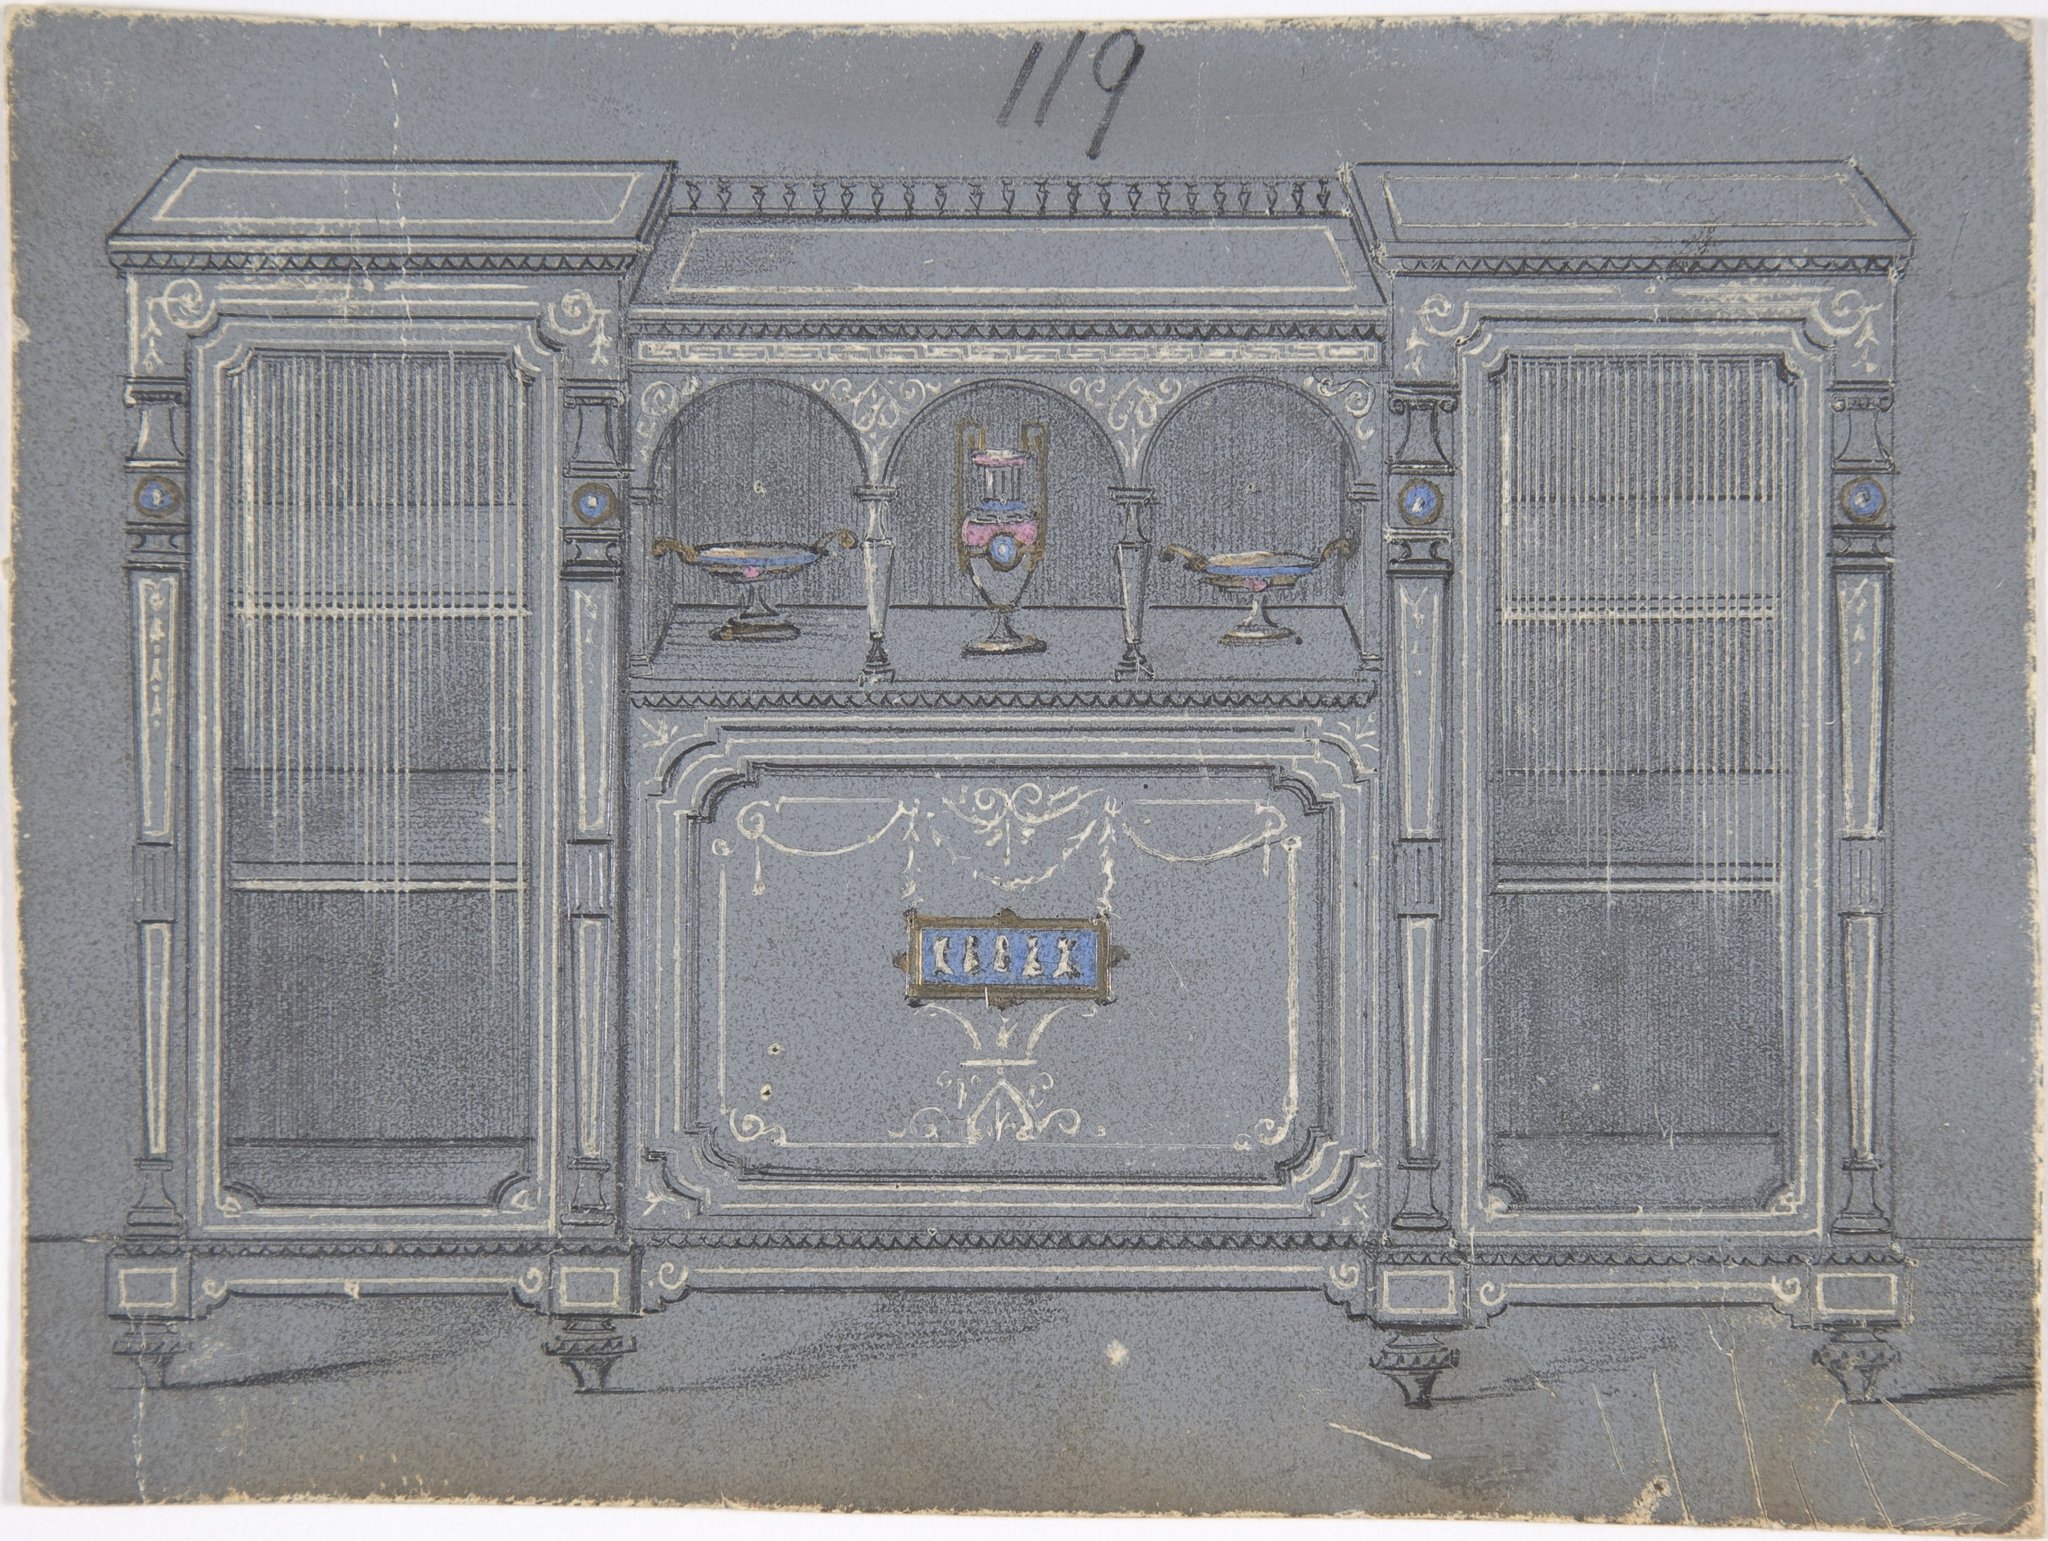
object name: drawing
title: Cabinet Design with a Porcelain Plaque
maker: anonymous, british, 19th century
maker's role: artist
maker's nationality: british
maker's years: 1800-1900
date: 1801-1900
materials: graphite, watercolor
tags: cabinets